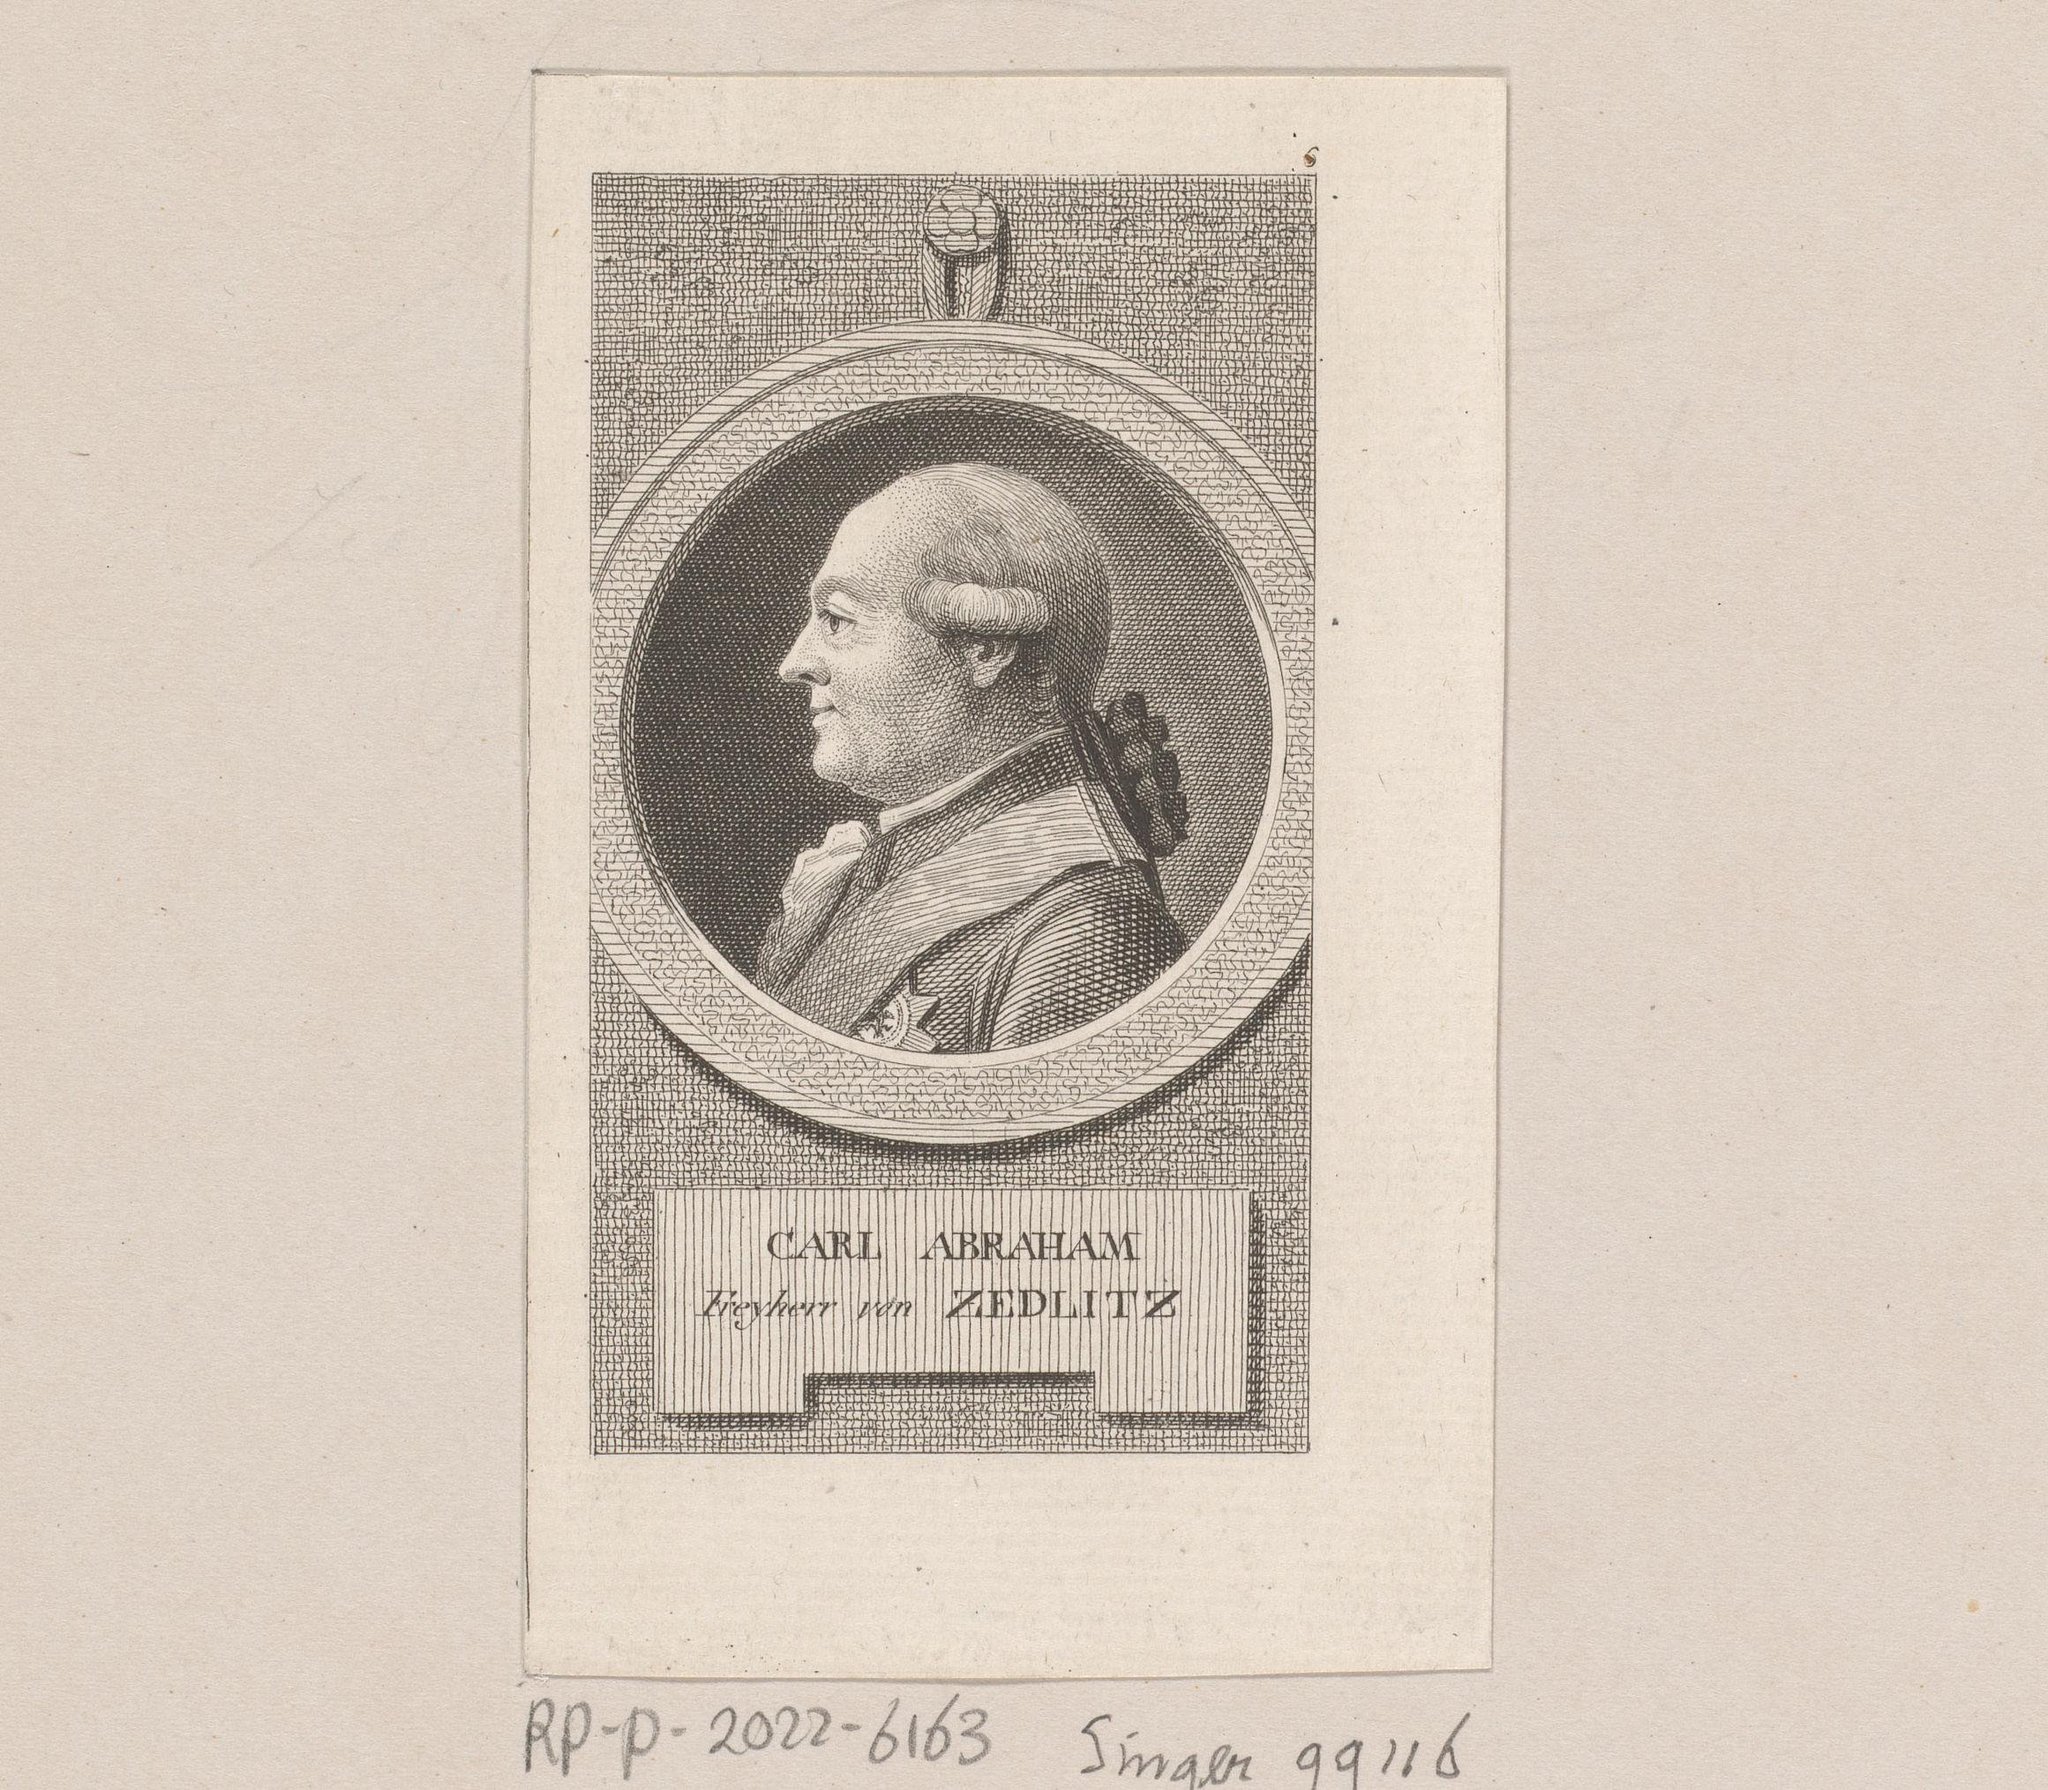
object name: print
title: Portret van Karl Abraham von Zedlitz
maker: Anonymous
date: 1810-1862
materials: paper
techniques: engraving, etching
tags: minister ~ government, historical persons